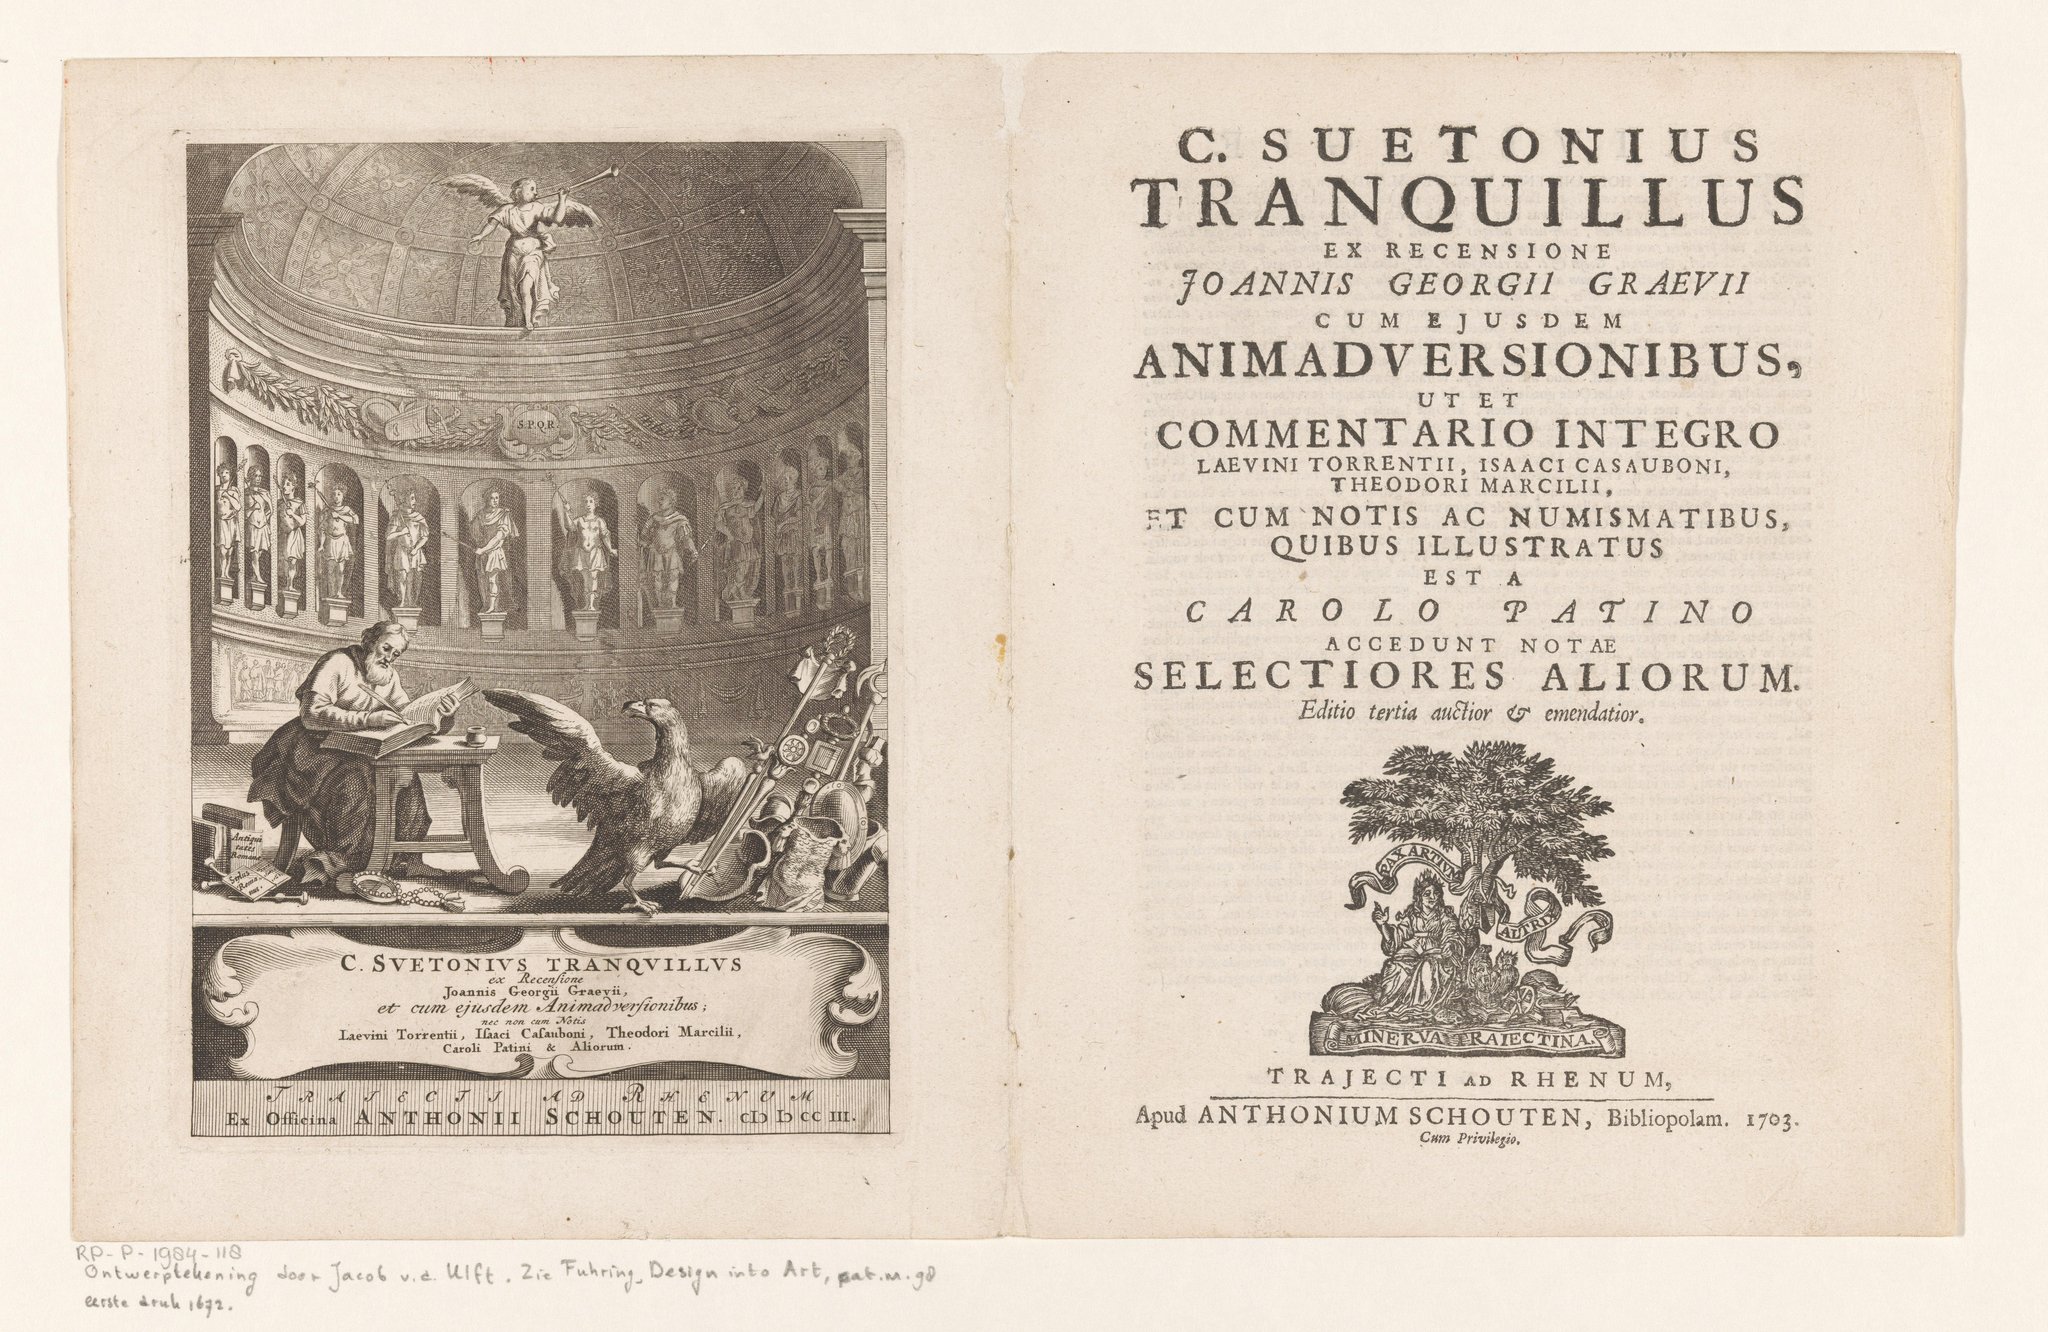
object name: titelblad, titelpagina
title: Suetonius in koepelgebouw en Minerva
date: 1703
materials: paper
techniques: engraving, etching, letterpress printing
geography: utrecht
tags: (story of) minerva (pallas, athena), other architectural details (cupola), writer, poet, author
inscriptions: collector's mark: Lugt 2228, collector's mark: Lugt 2760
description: Links: Een man, mogelijk Gaius Suetonius Tranquillus, zit aan een tafel en schrijft in een boek. Rechts een adelaar met wapentrofeeën. In de achtergrond een koepel met beelden van antieke helden in nissen. Daarboven Fama blazend op een bazuin. Rechts: Gedrukte titelpagina met drukkersmerk met Minerva zittend onder een boom en het motto Pax artium altrix / Minerva Traiectina.